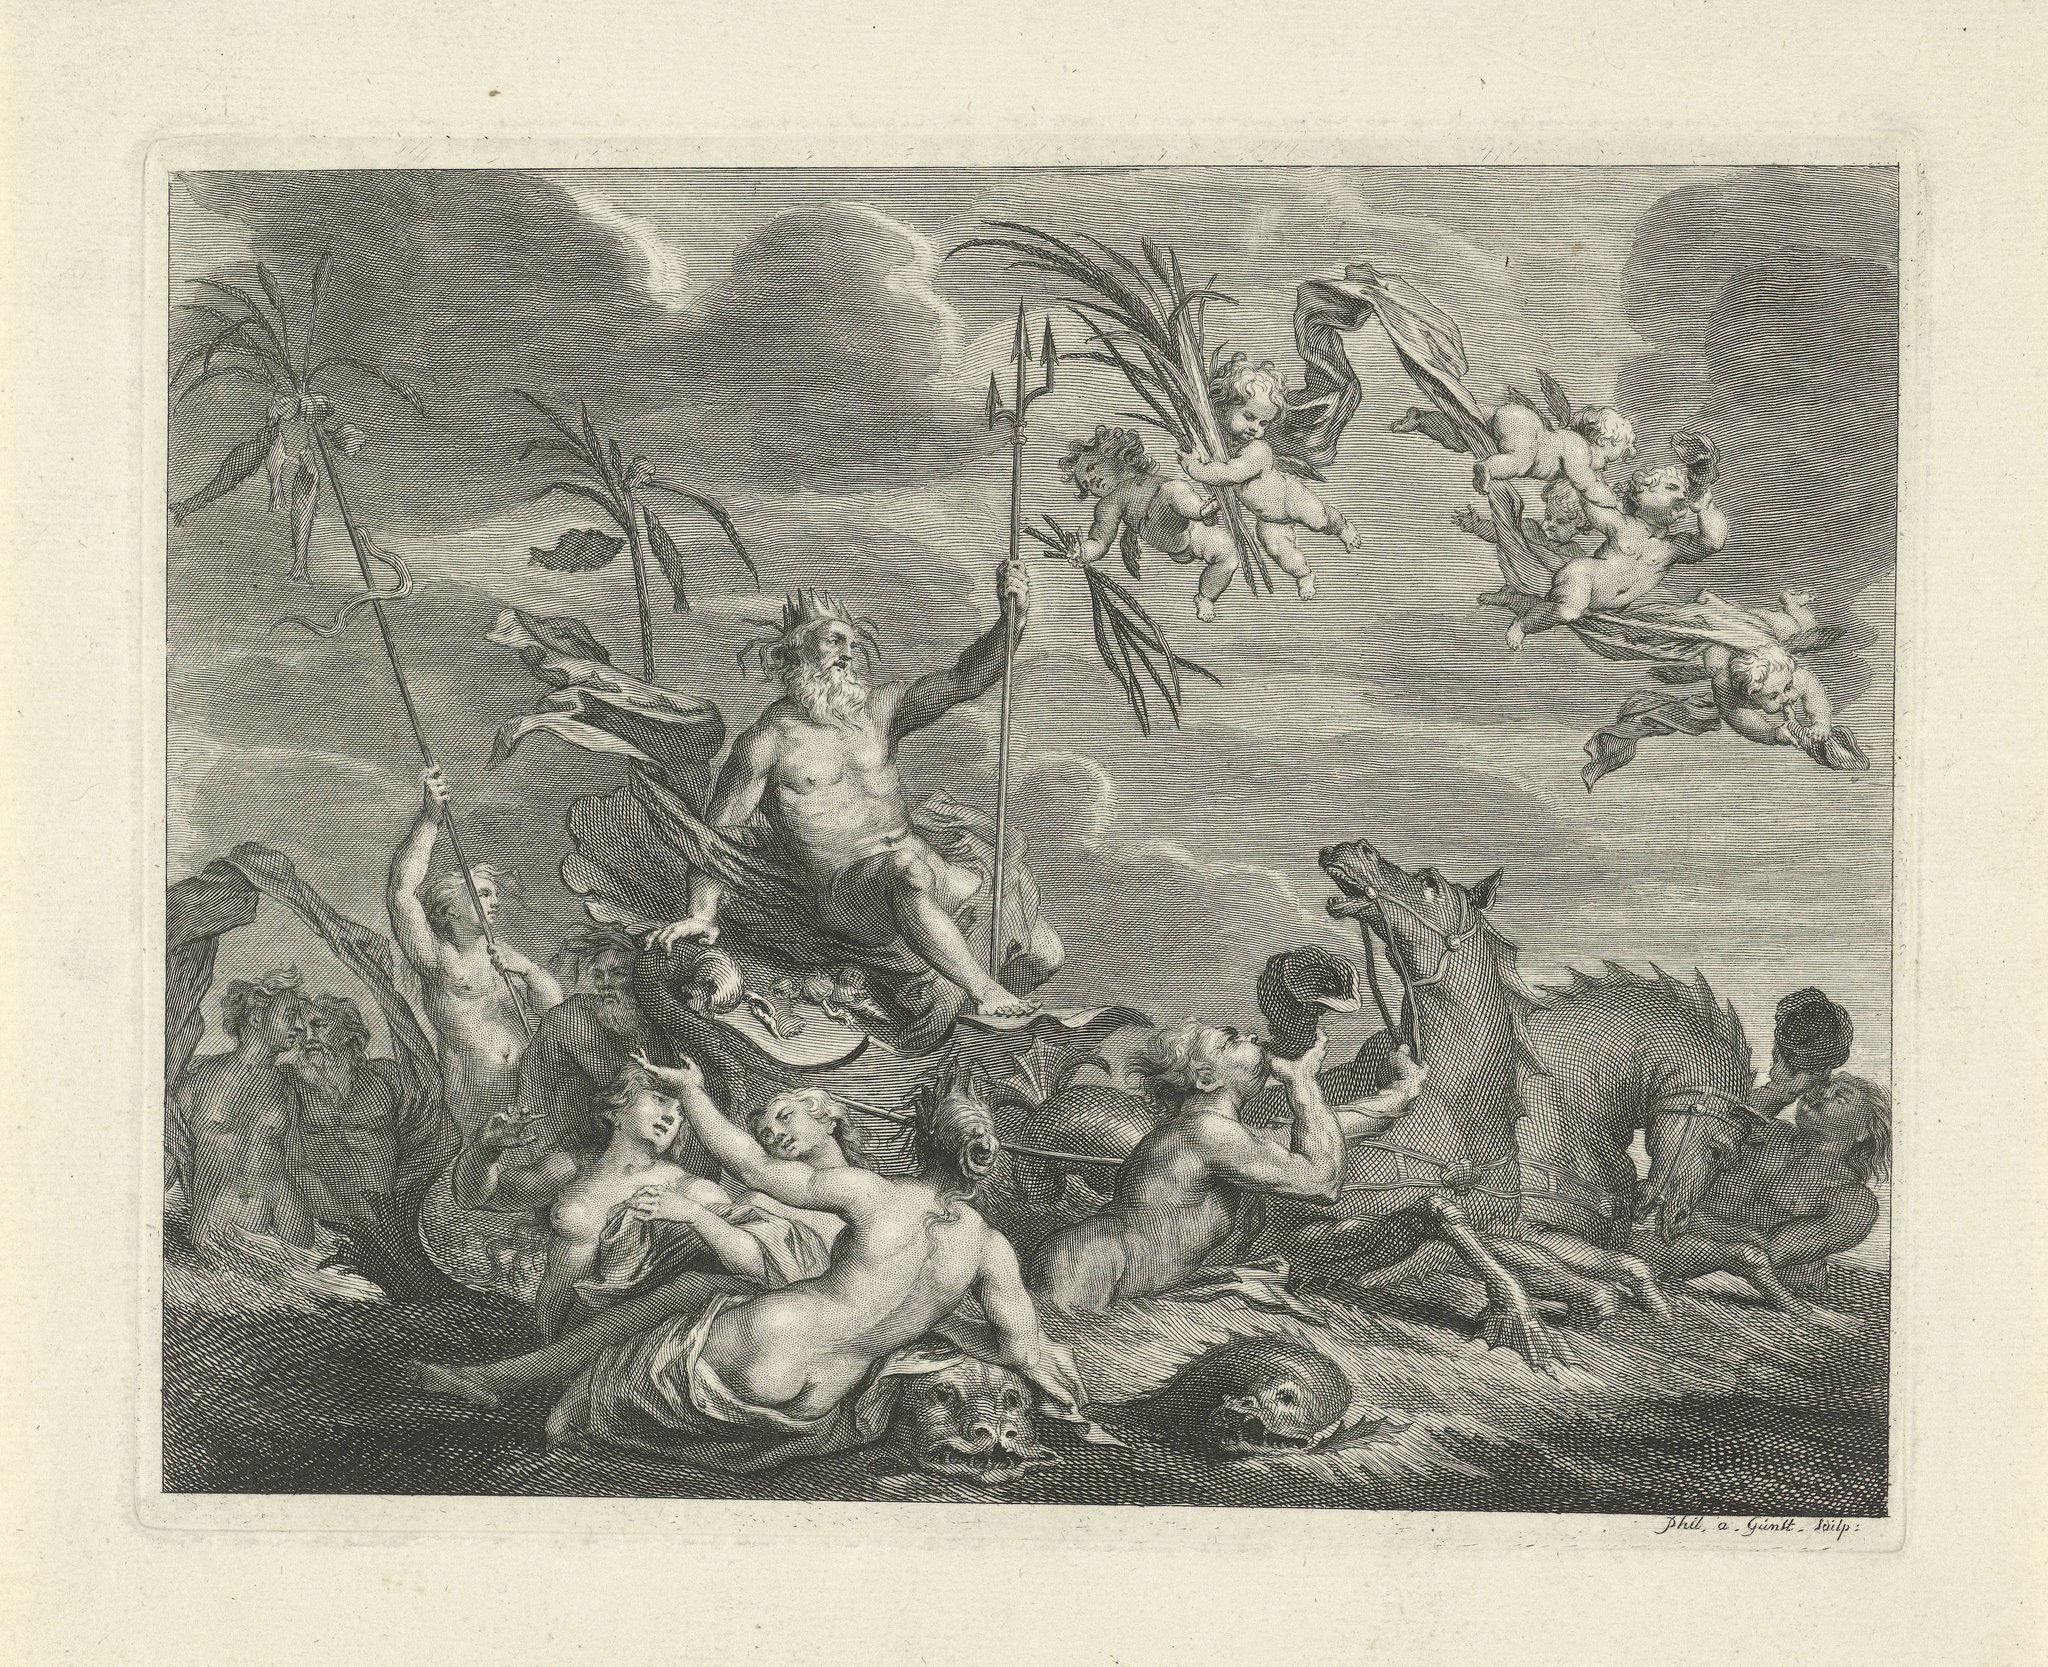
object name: print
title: Neptunus bedwingt de zondvloed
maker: philip van gunst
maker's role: print maker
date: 1685-1732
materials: paper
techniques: engraving, etching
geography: amsterdam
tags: offspring, companion(s), train etc. of neptune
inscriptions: collector's mark: Lugt 2228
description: Neptunus en zijn gevolg duiken op uit de zee. Neptunus is gezeten op een schelp die wordt getrokken door zeepaarden. In de lucht vliegen enkele putti. Neptunus maakt een einde aan de zondvloed die de wereld teisterde.